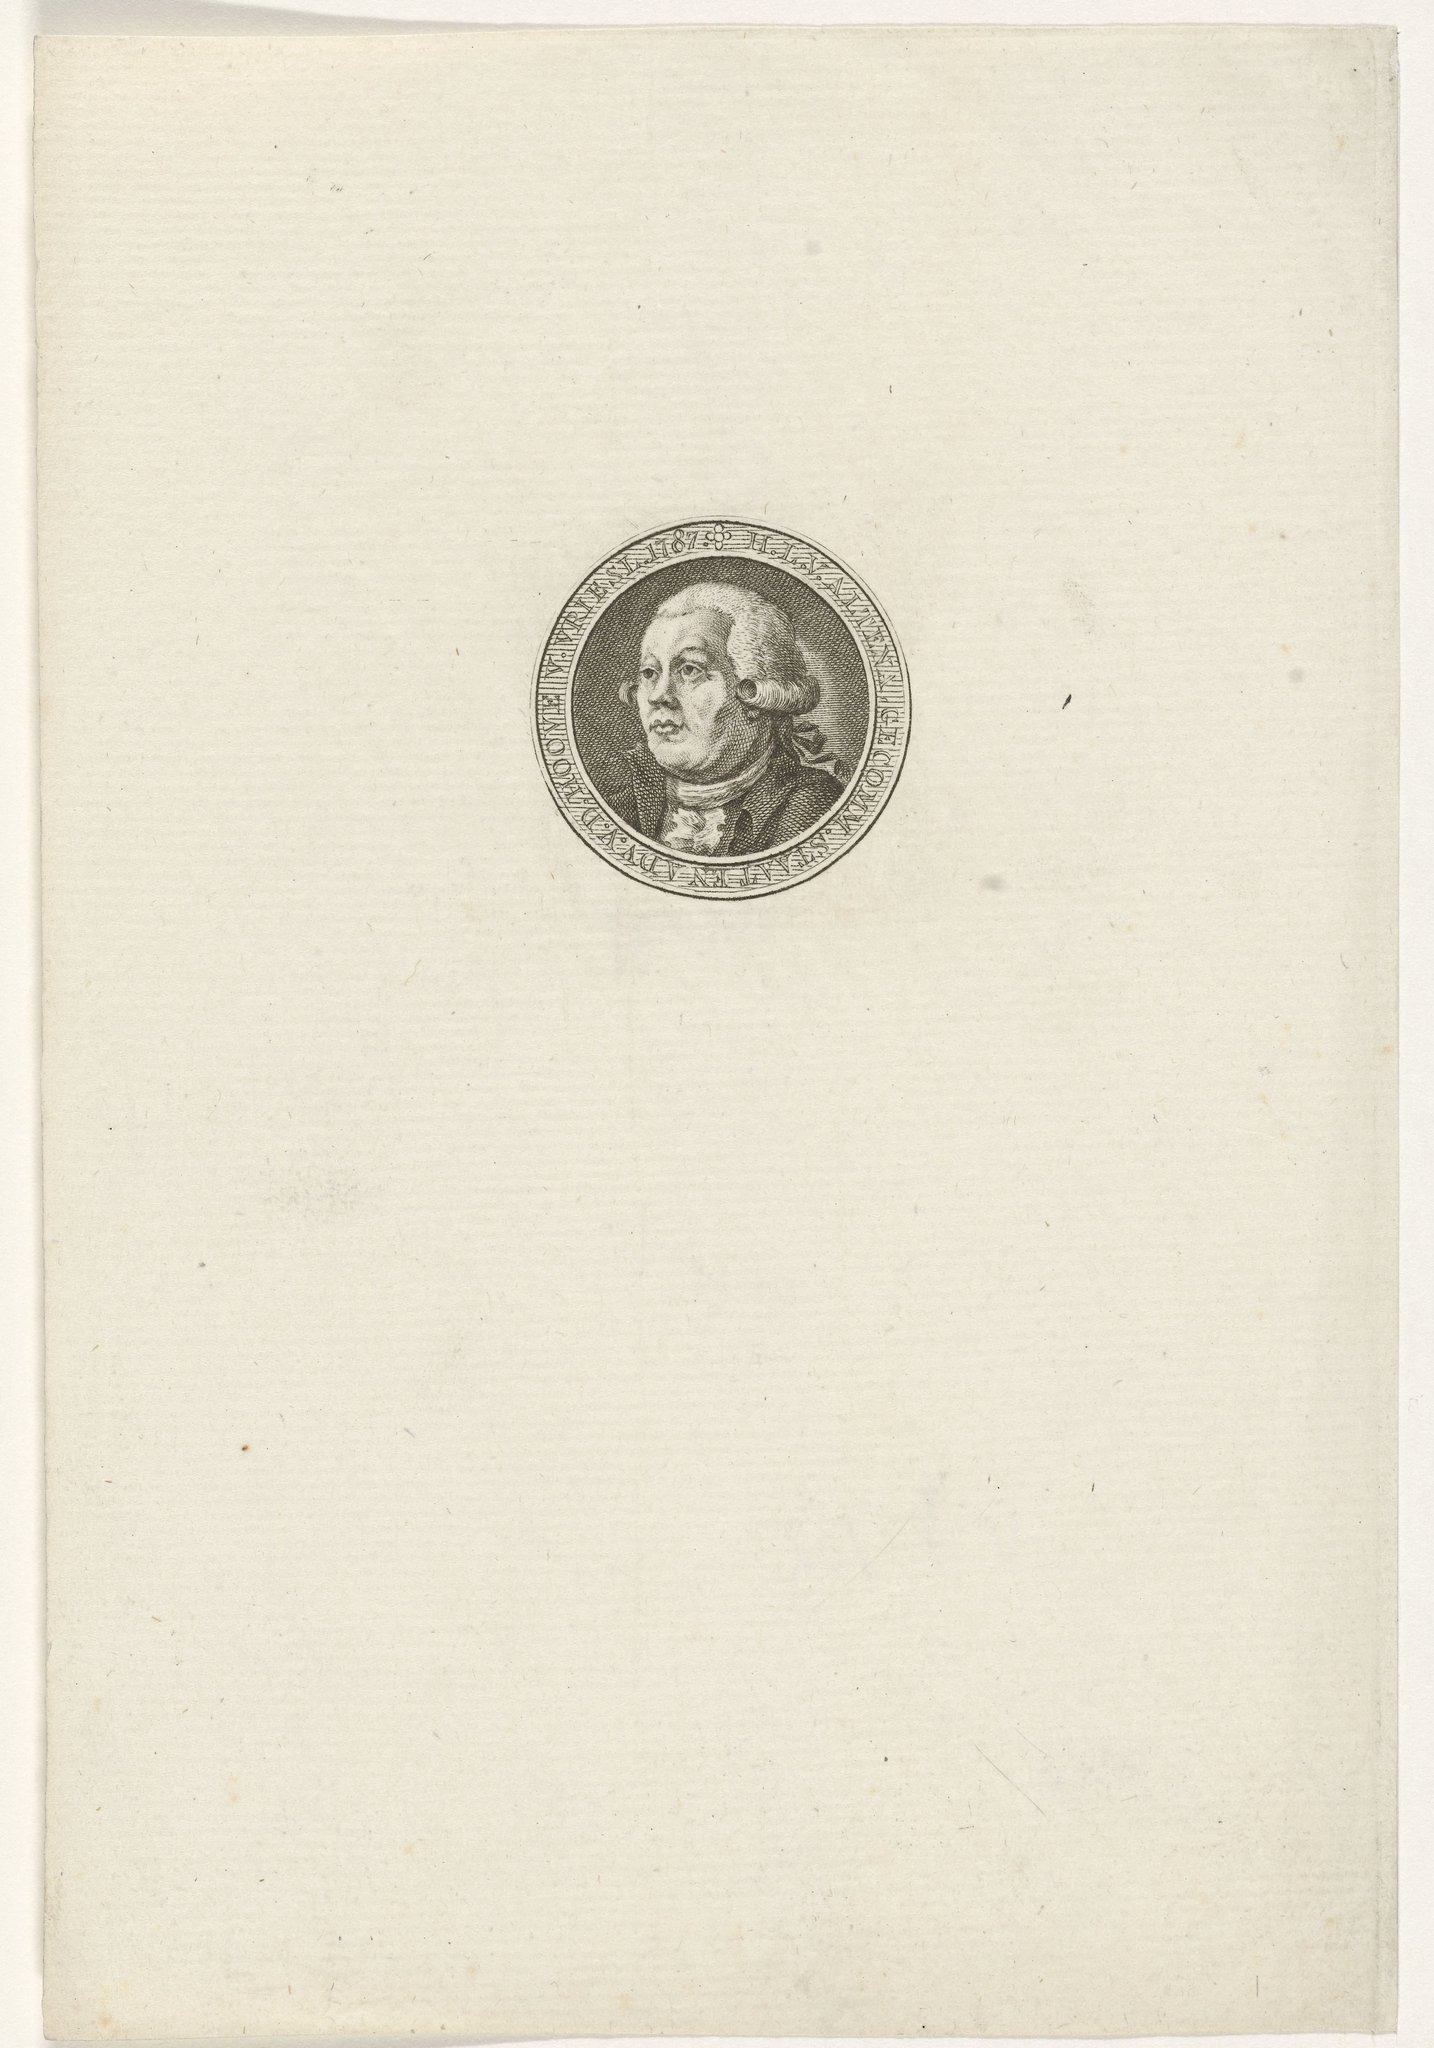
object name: print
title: Portret van Hector Livius van Altena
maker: abraham jacobsz. hulk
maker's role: print maker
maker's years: 1751-1817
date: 1787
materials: paper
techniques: engraving, etching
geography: paris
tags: leeuwarden, hector livius van altena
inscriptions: collector's mark: Lugt 2228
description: Buste van Hector Livius van Altena naar links in een medaillon met randschrift in het Nederlands.